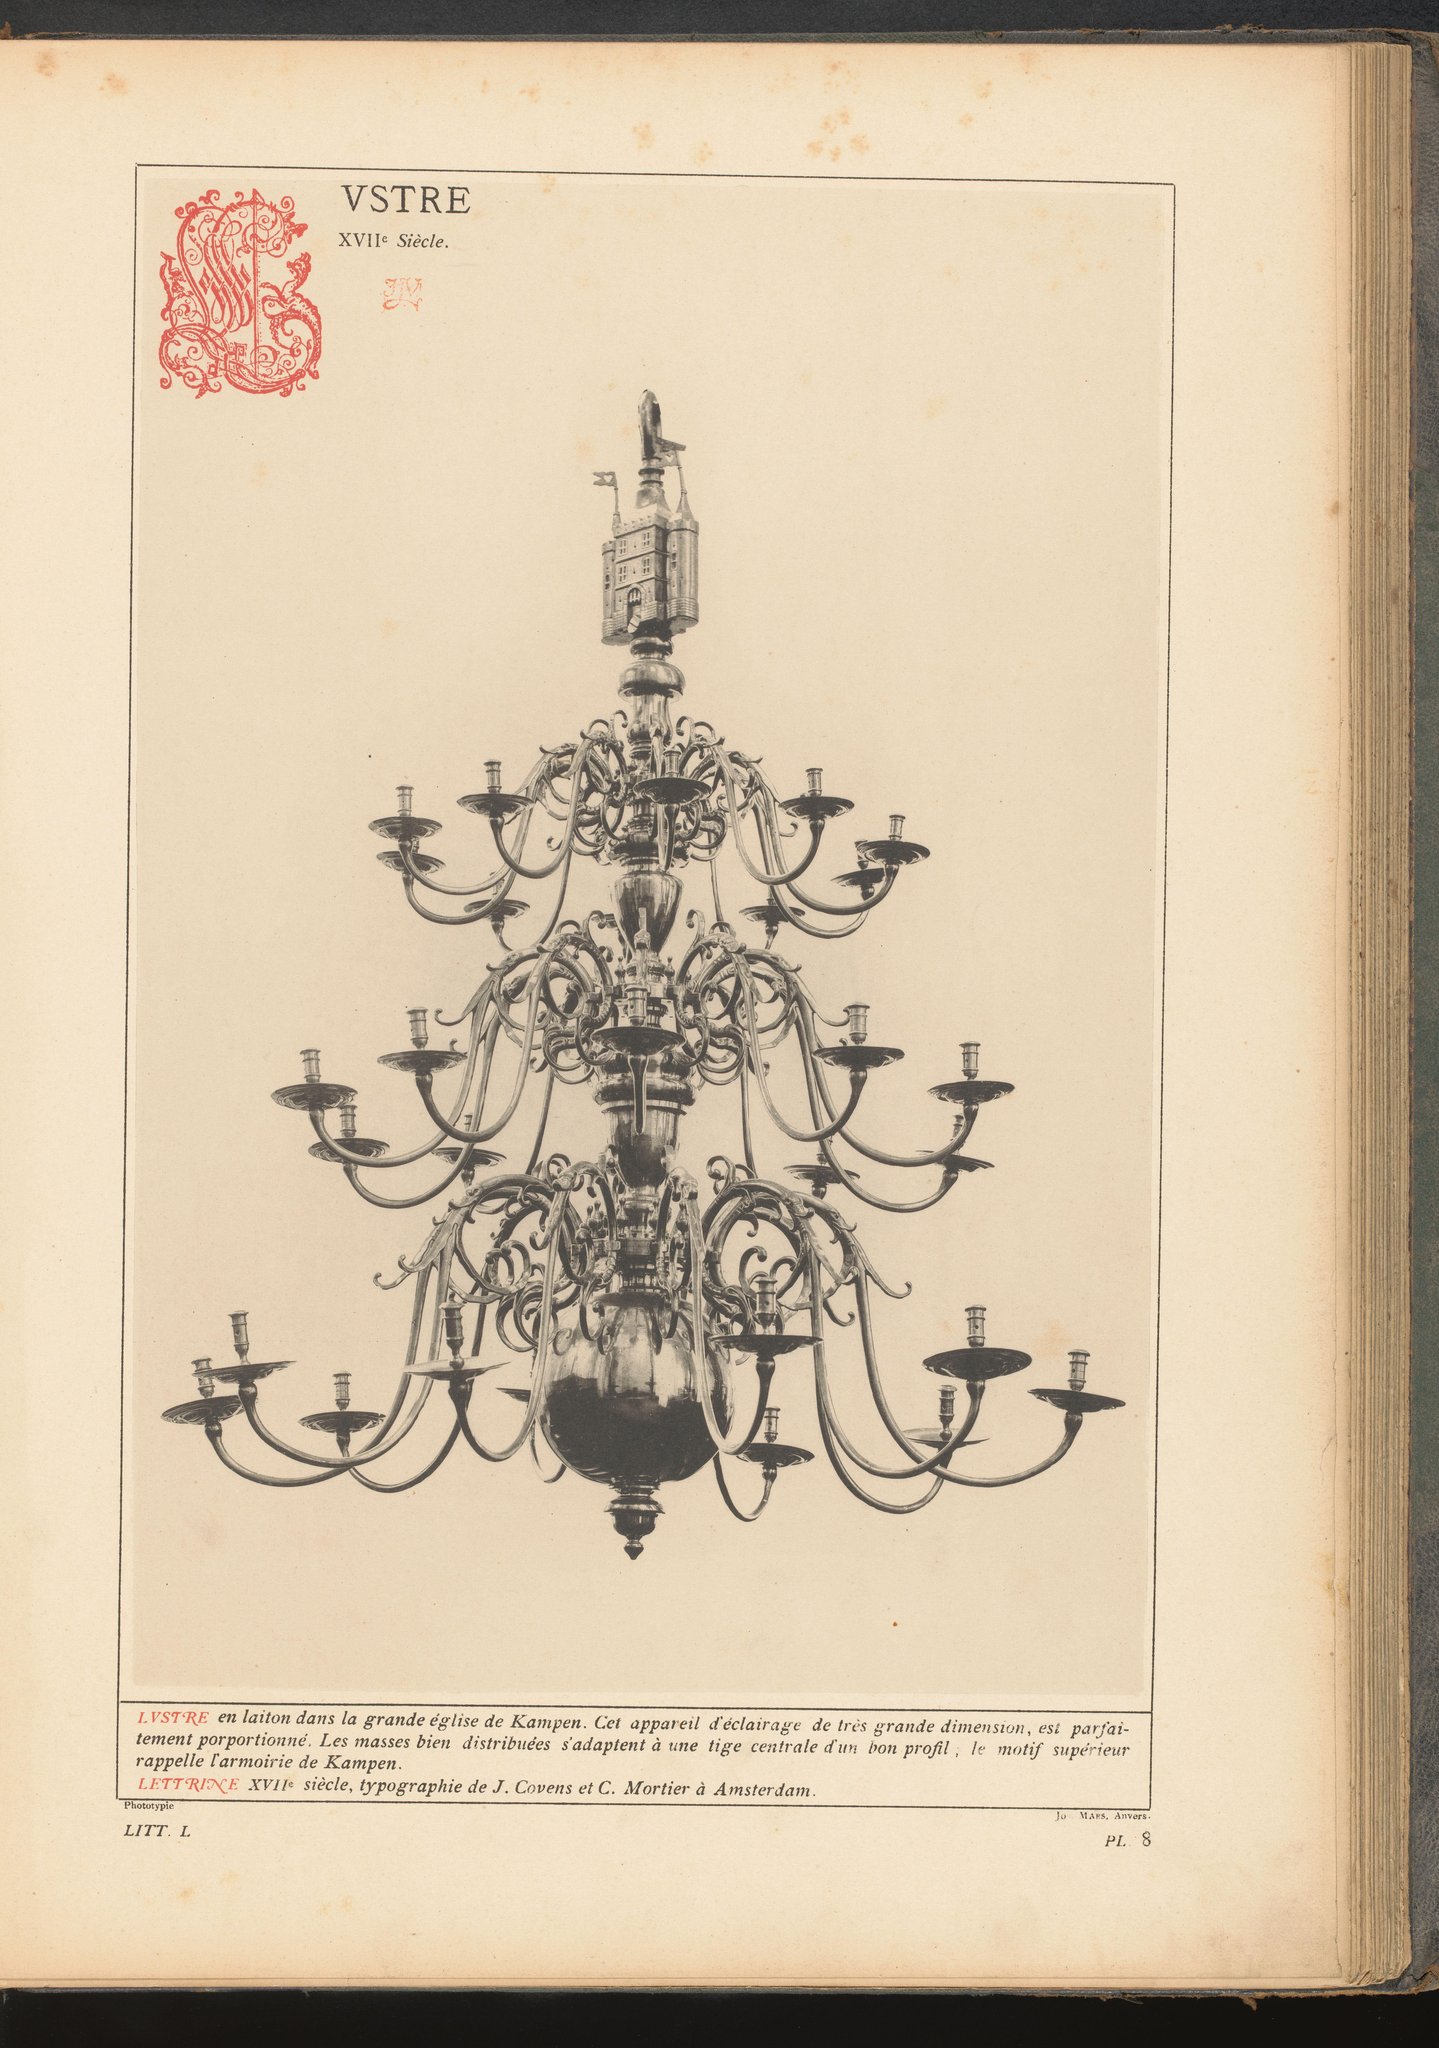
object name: page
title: Lustre, XVIIe Siècle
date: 1875-1880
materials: paper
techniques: photograph, photolithography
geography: antwerp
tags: chandelier, candelabrum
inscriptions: monogram: ‘JJvY’, inscription: ‘LUSTRE en laiton (...)’, inscription: ‘LITT. L. - PL. 8’